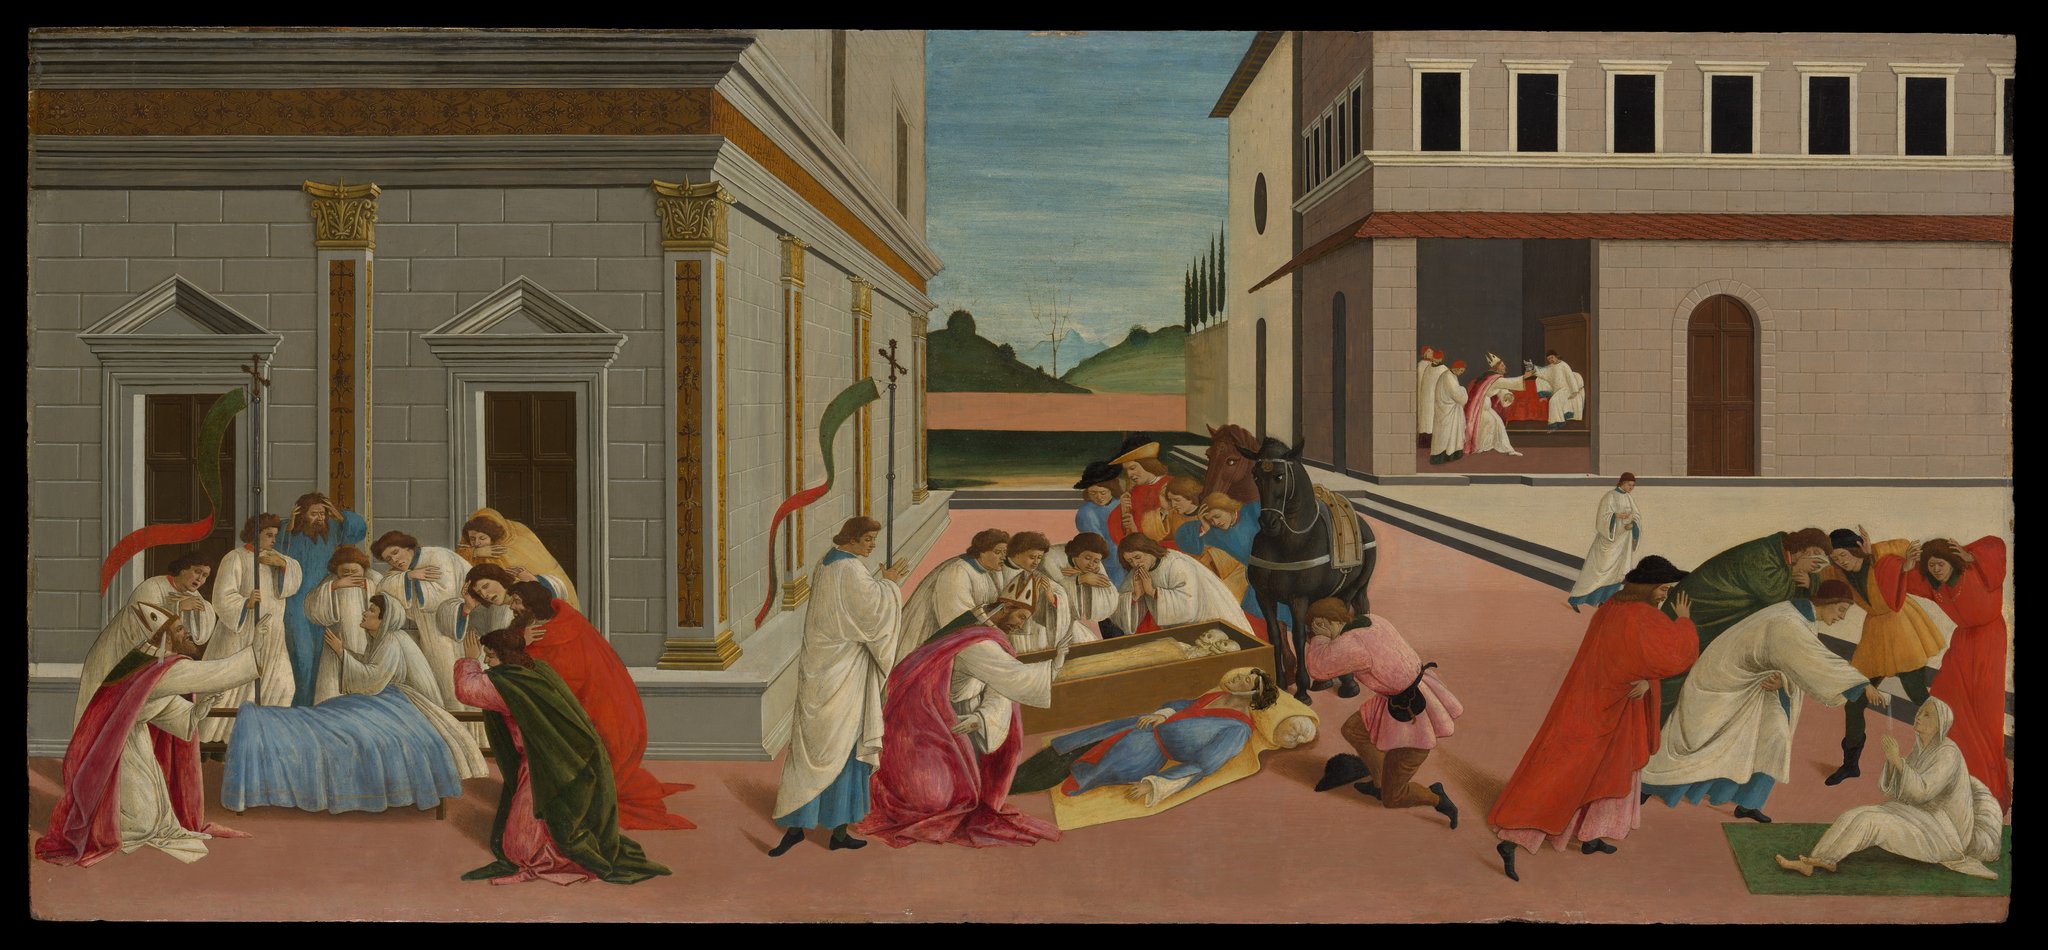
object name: painting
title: Three Miracles of Saint Zenobius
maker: botticelli (alessandro di mariano filipepi)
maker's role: artist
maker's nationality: italian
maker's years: 1444-1510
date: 1500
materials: paint, wood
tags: men,horses,saint zenobius